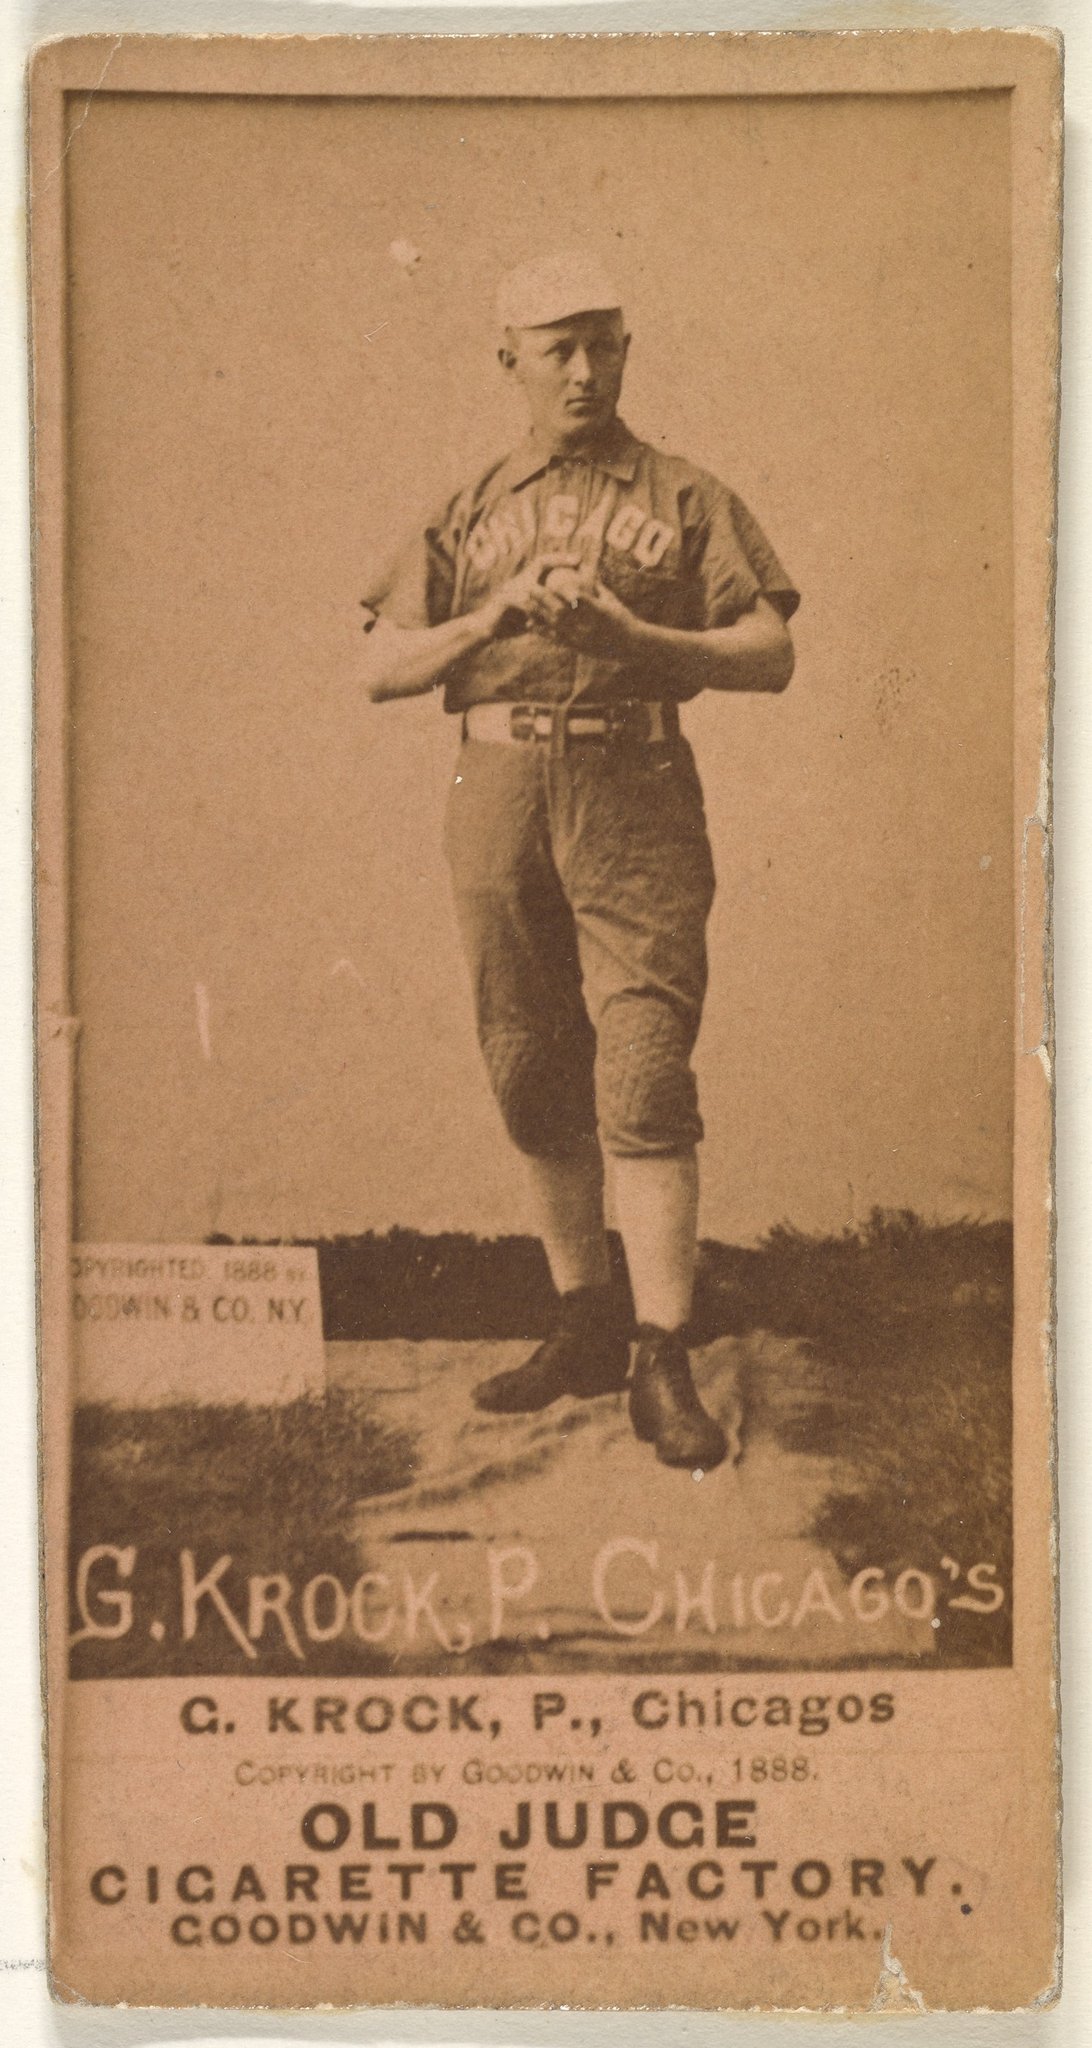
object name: baseball card, photograph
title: August H. "Gus" Krock, Pitcher, Chicago, from the Old Judge series (N172) for Old Judge Cigarettes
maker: goodwin & company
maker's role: publisher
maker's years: 1850-1950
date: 1888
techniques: albumen silver print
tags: men,portraits,baseball,athletes